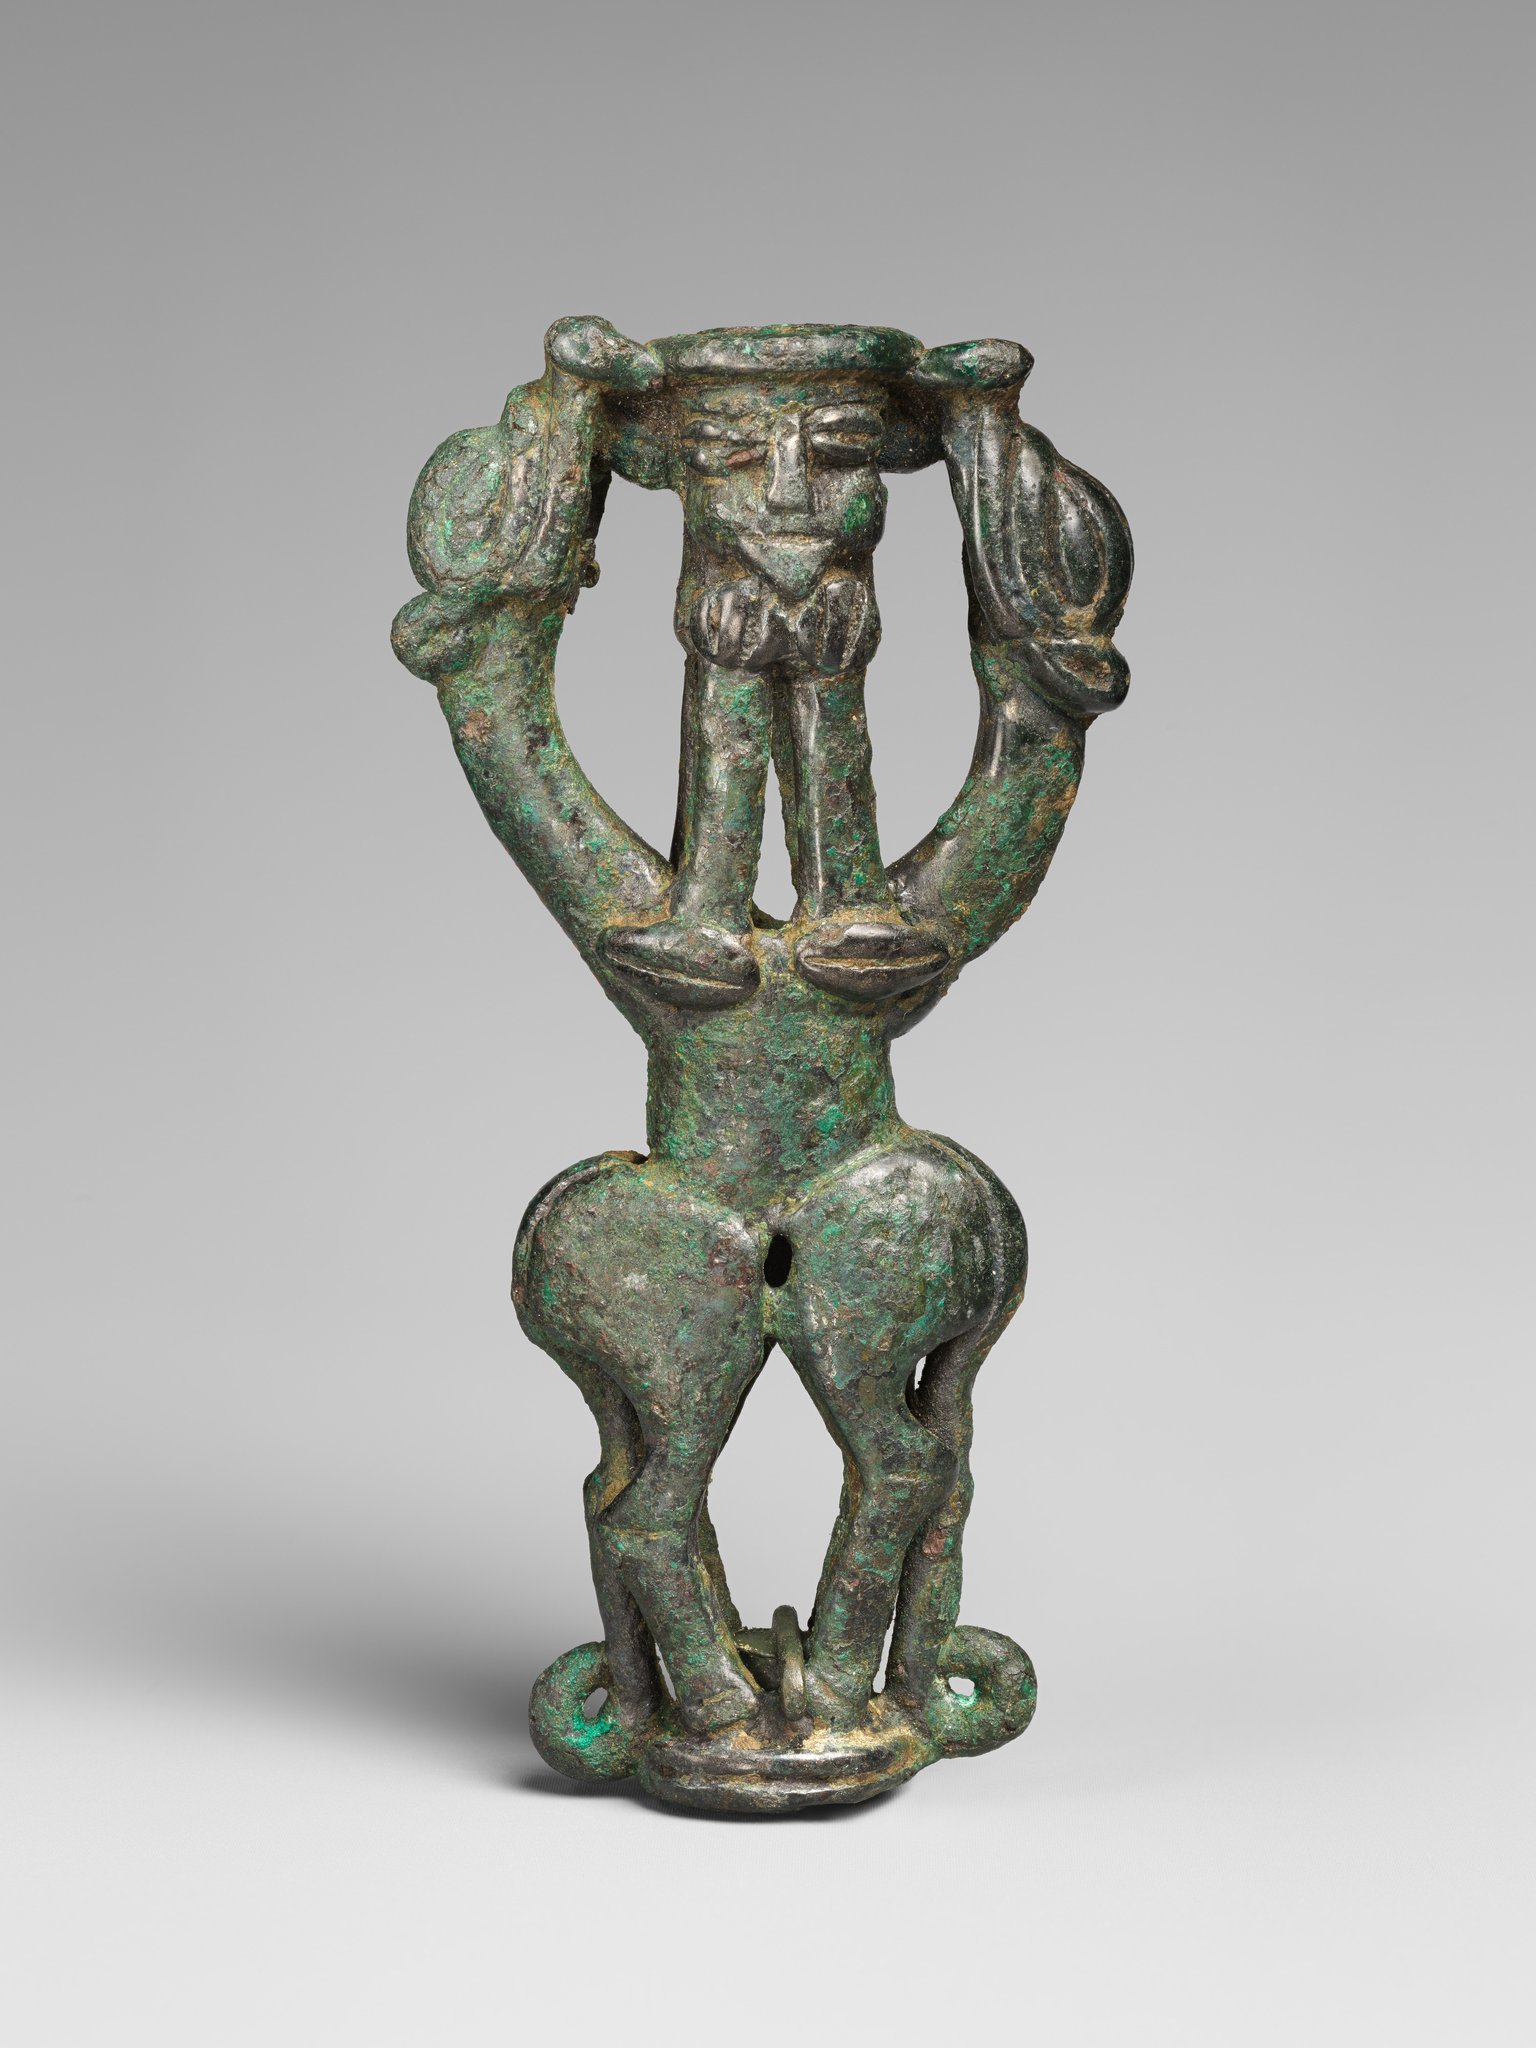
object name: sculpture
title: Top for standard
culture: iranian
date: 800-601 BCE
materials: bronze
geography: iran, probably from luristan